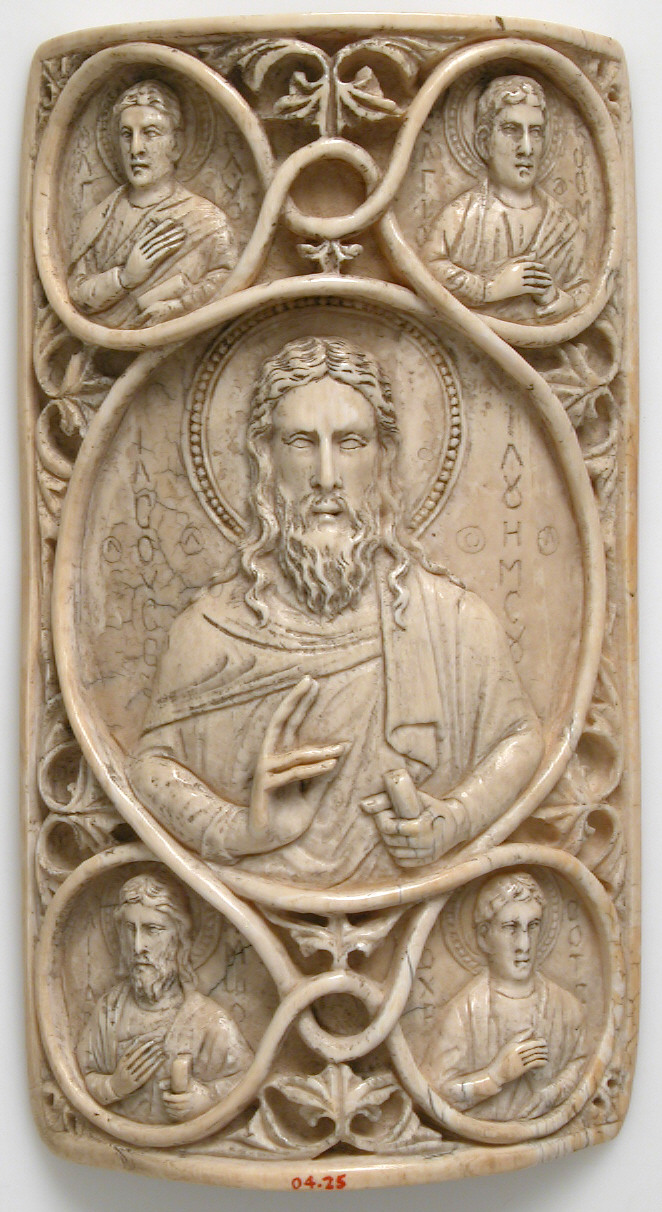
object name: panel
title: Panel with John the Baptist and other saints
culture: byzantine or european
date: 1801-1900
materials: ivory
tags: christ